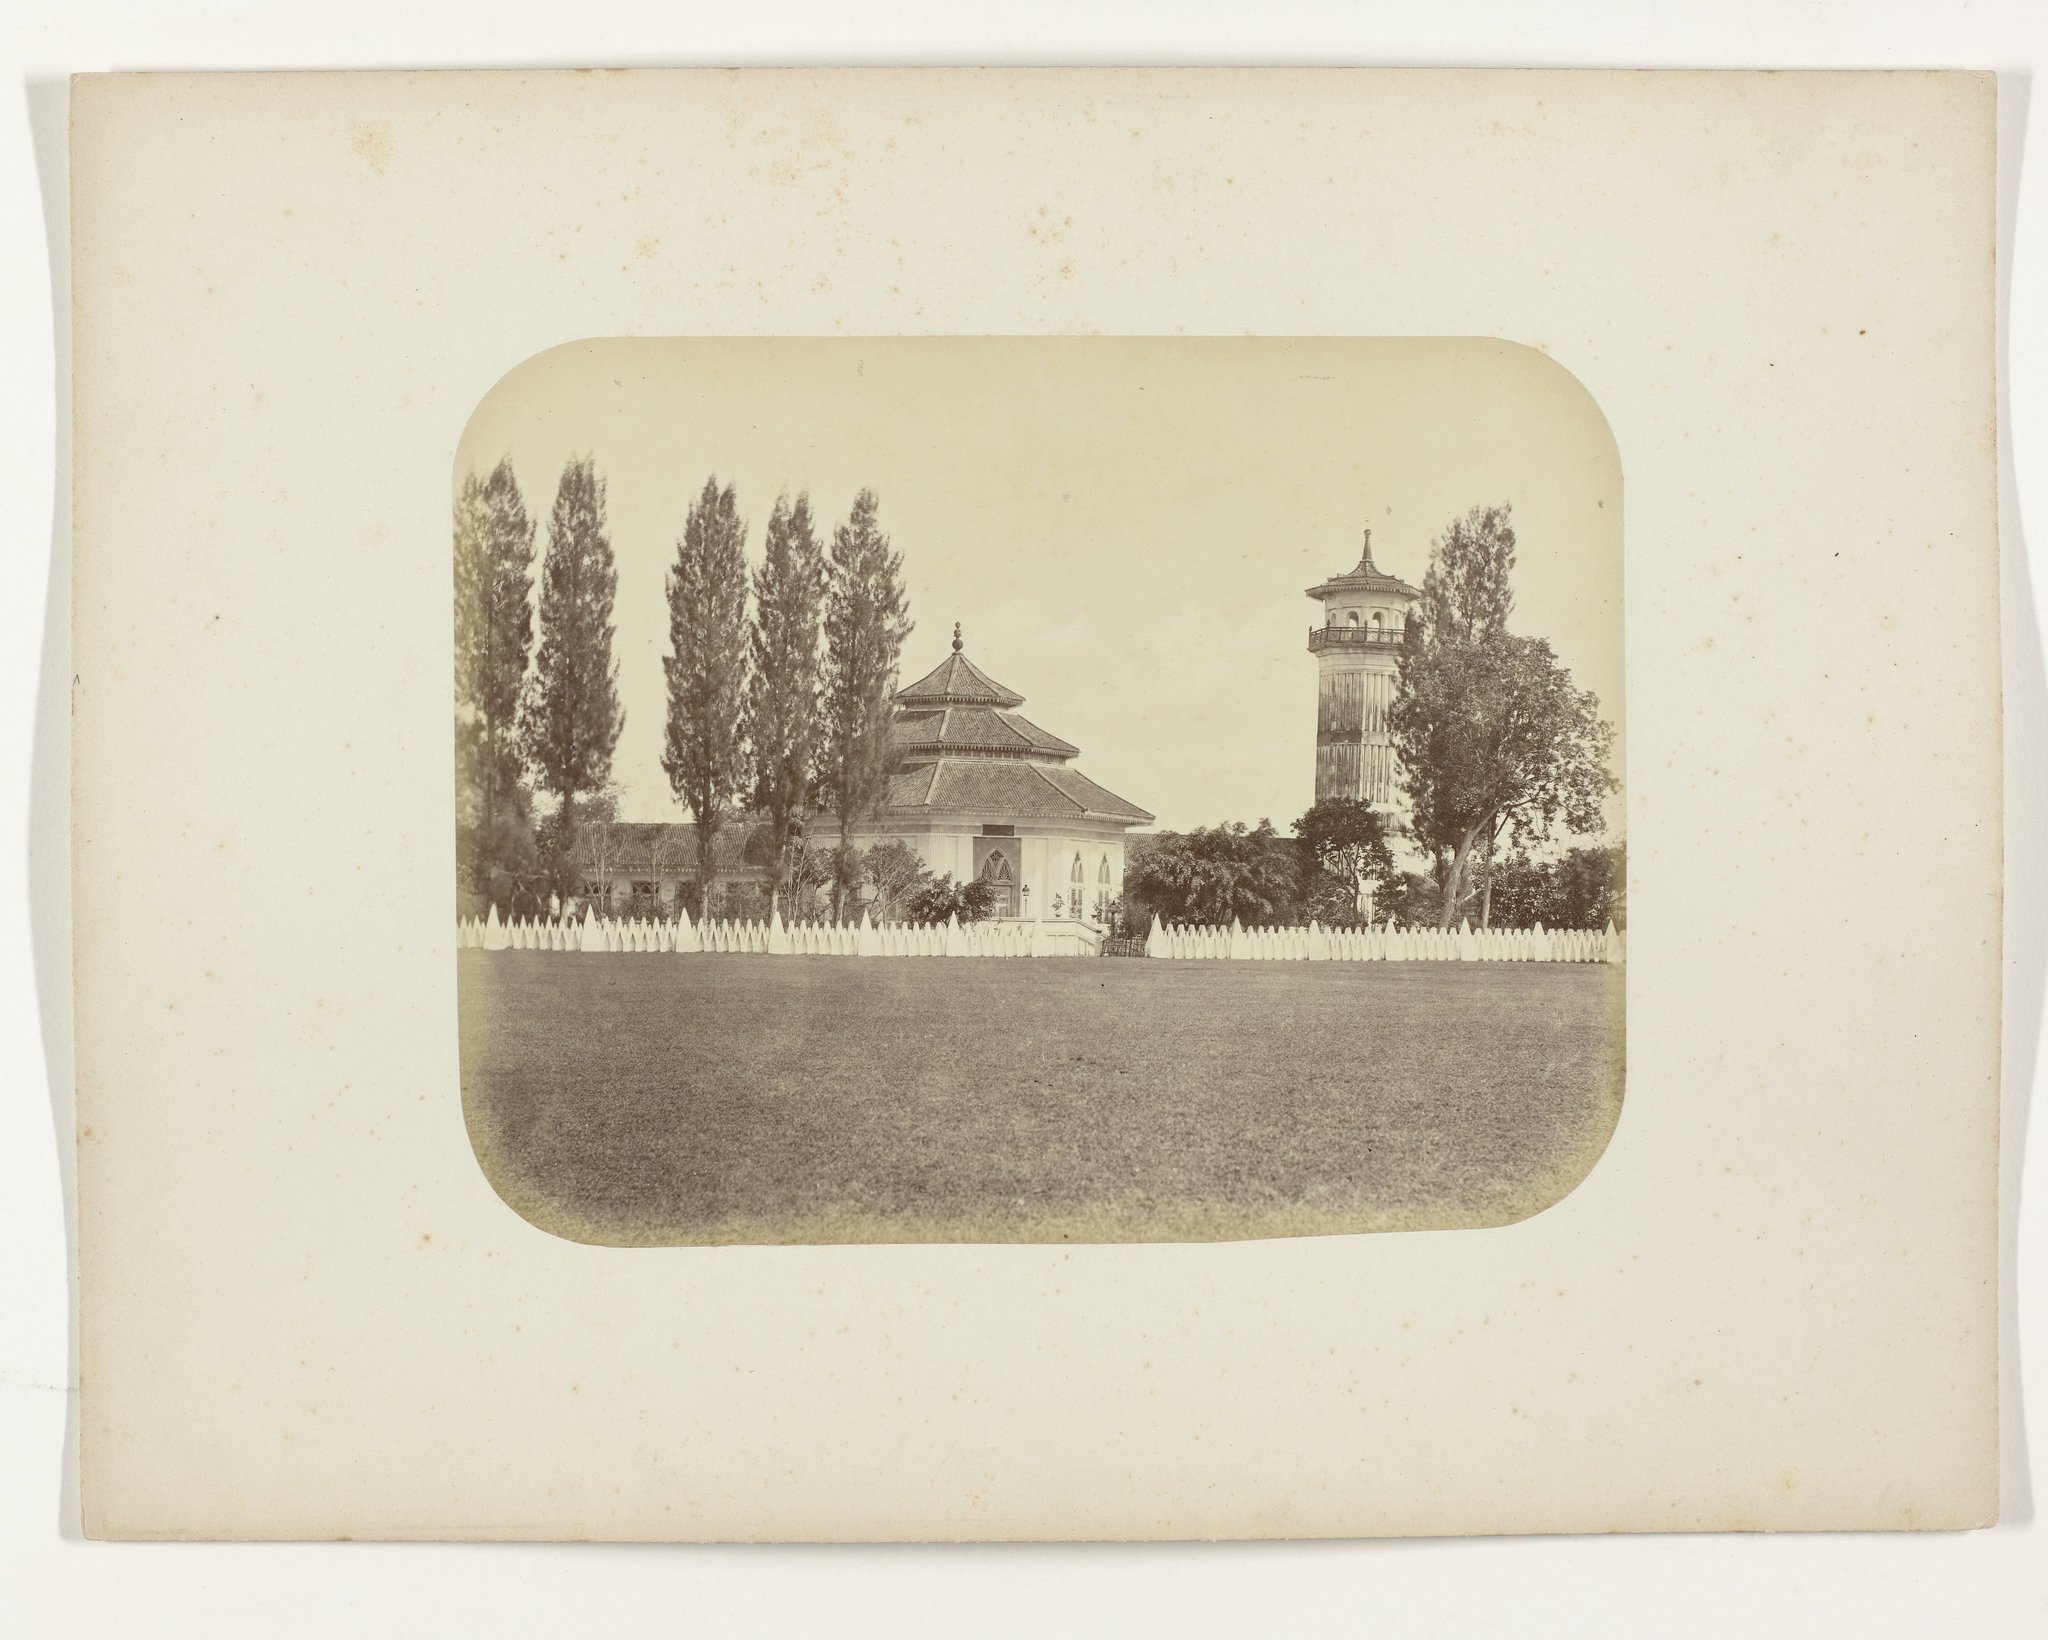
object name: photograph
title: De moskee van Surabaya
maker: herman salzwedel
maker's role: fotograaf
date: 1876-1884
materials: photographic support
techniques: albumen print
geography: surabaya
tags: the hague, colonial system, temple, shrine ~ islam, mohammedanism, surabaya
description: De moskee van Surabaya links met minaret rechts. Op de voorgrond een weiland en voor de moskee over de gehele breedte een stenen muur. Onderdeel van het fotoalbum door de Soerabayasche Vereeniging van Suikerfabrikanten aangeboden aan Frederik Beyerinck, resident van Soerabaja.